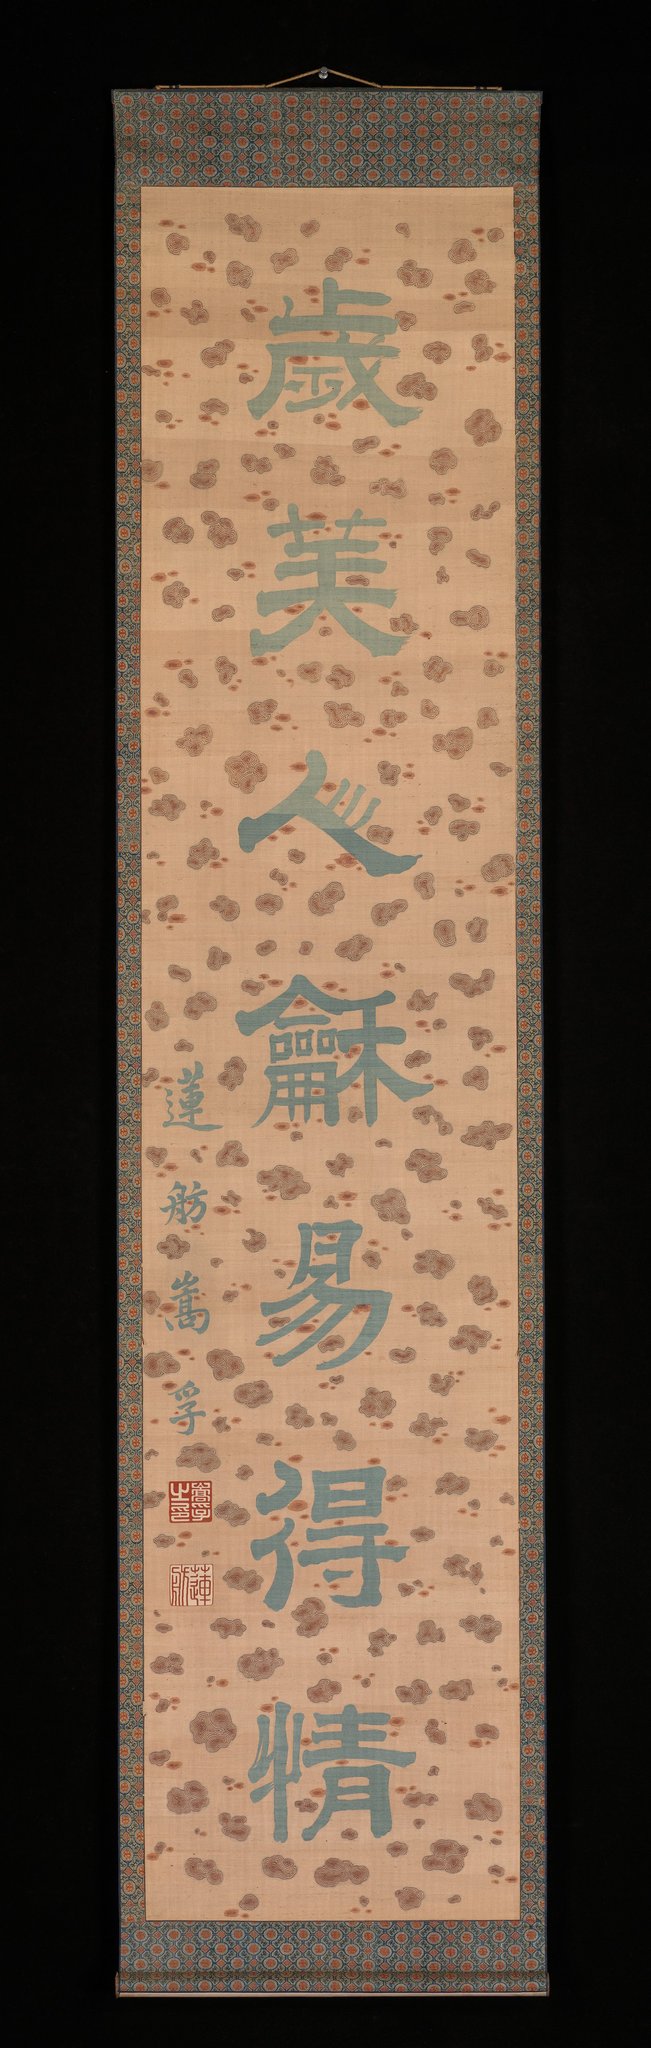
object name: kesi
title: Calligraphy Couplet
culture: chinese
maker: lianfang songfou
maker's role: calligrapher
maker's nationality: chinese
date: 1801-1900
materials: silk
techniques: tapestry